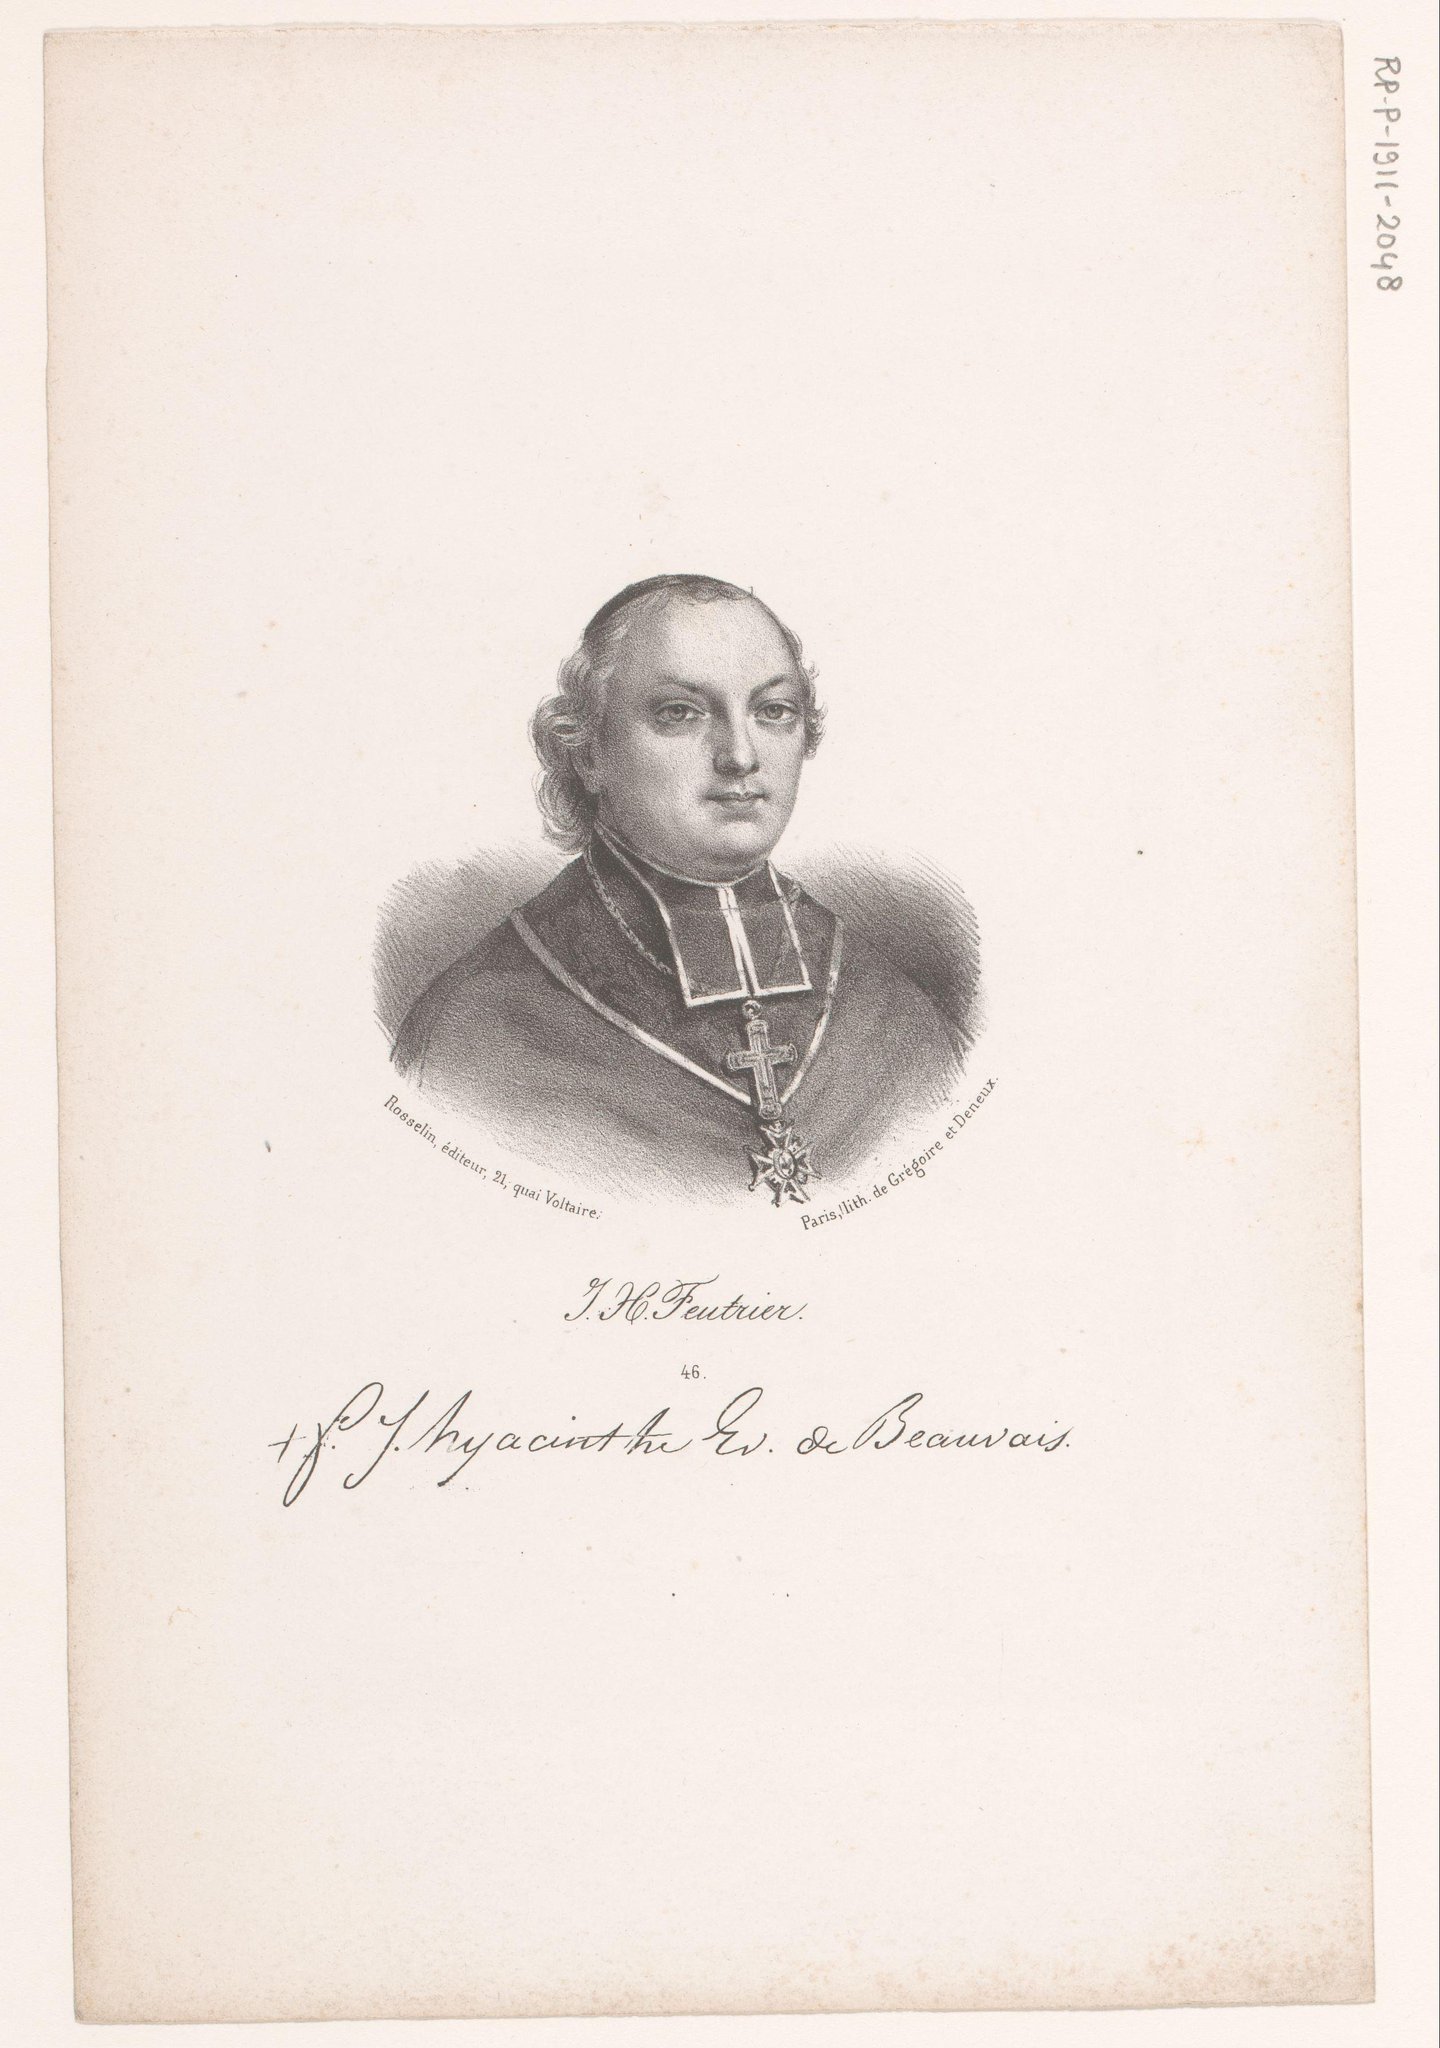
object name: print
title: Beroemde personen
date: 1844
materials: paper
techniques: lithograph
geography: paris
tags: paris, politician, historical persons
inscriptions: collector's mark: Lugt 2228a